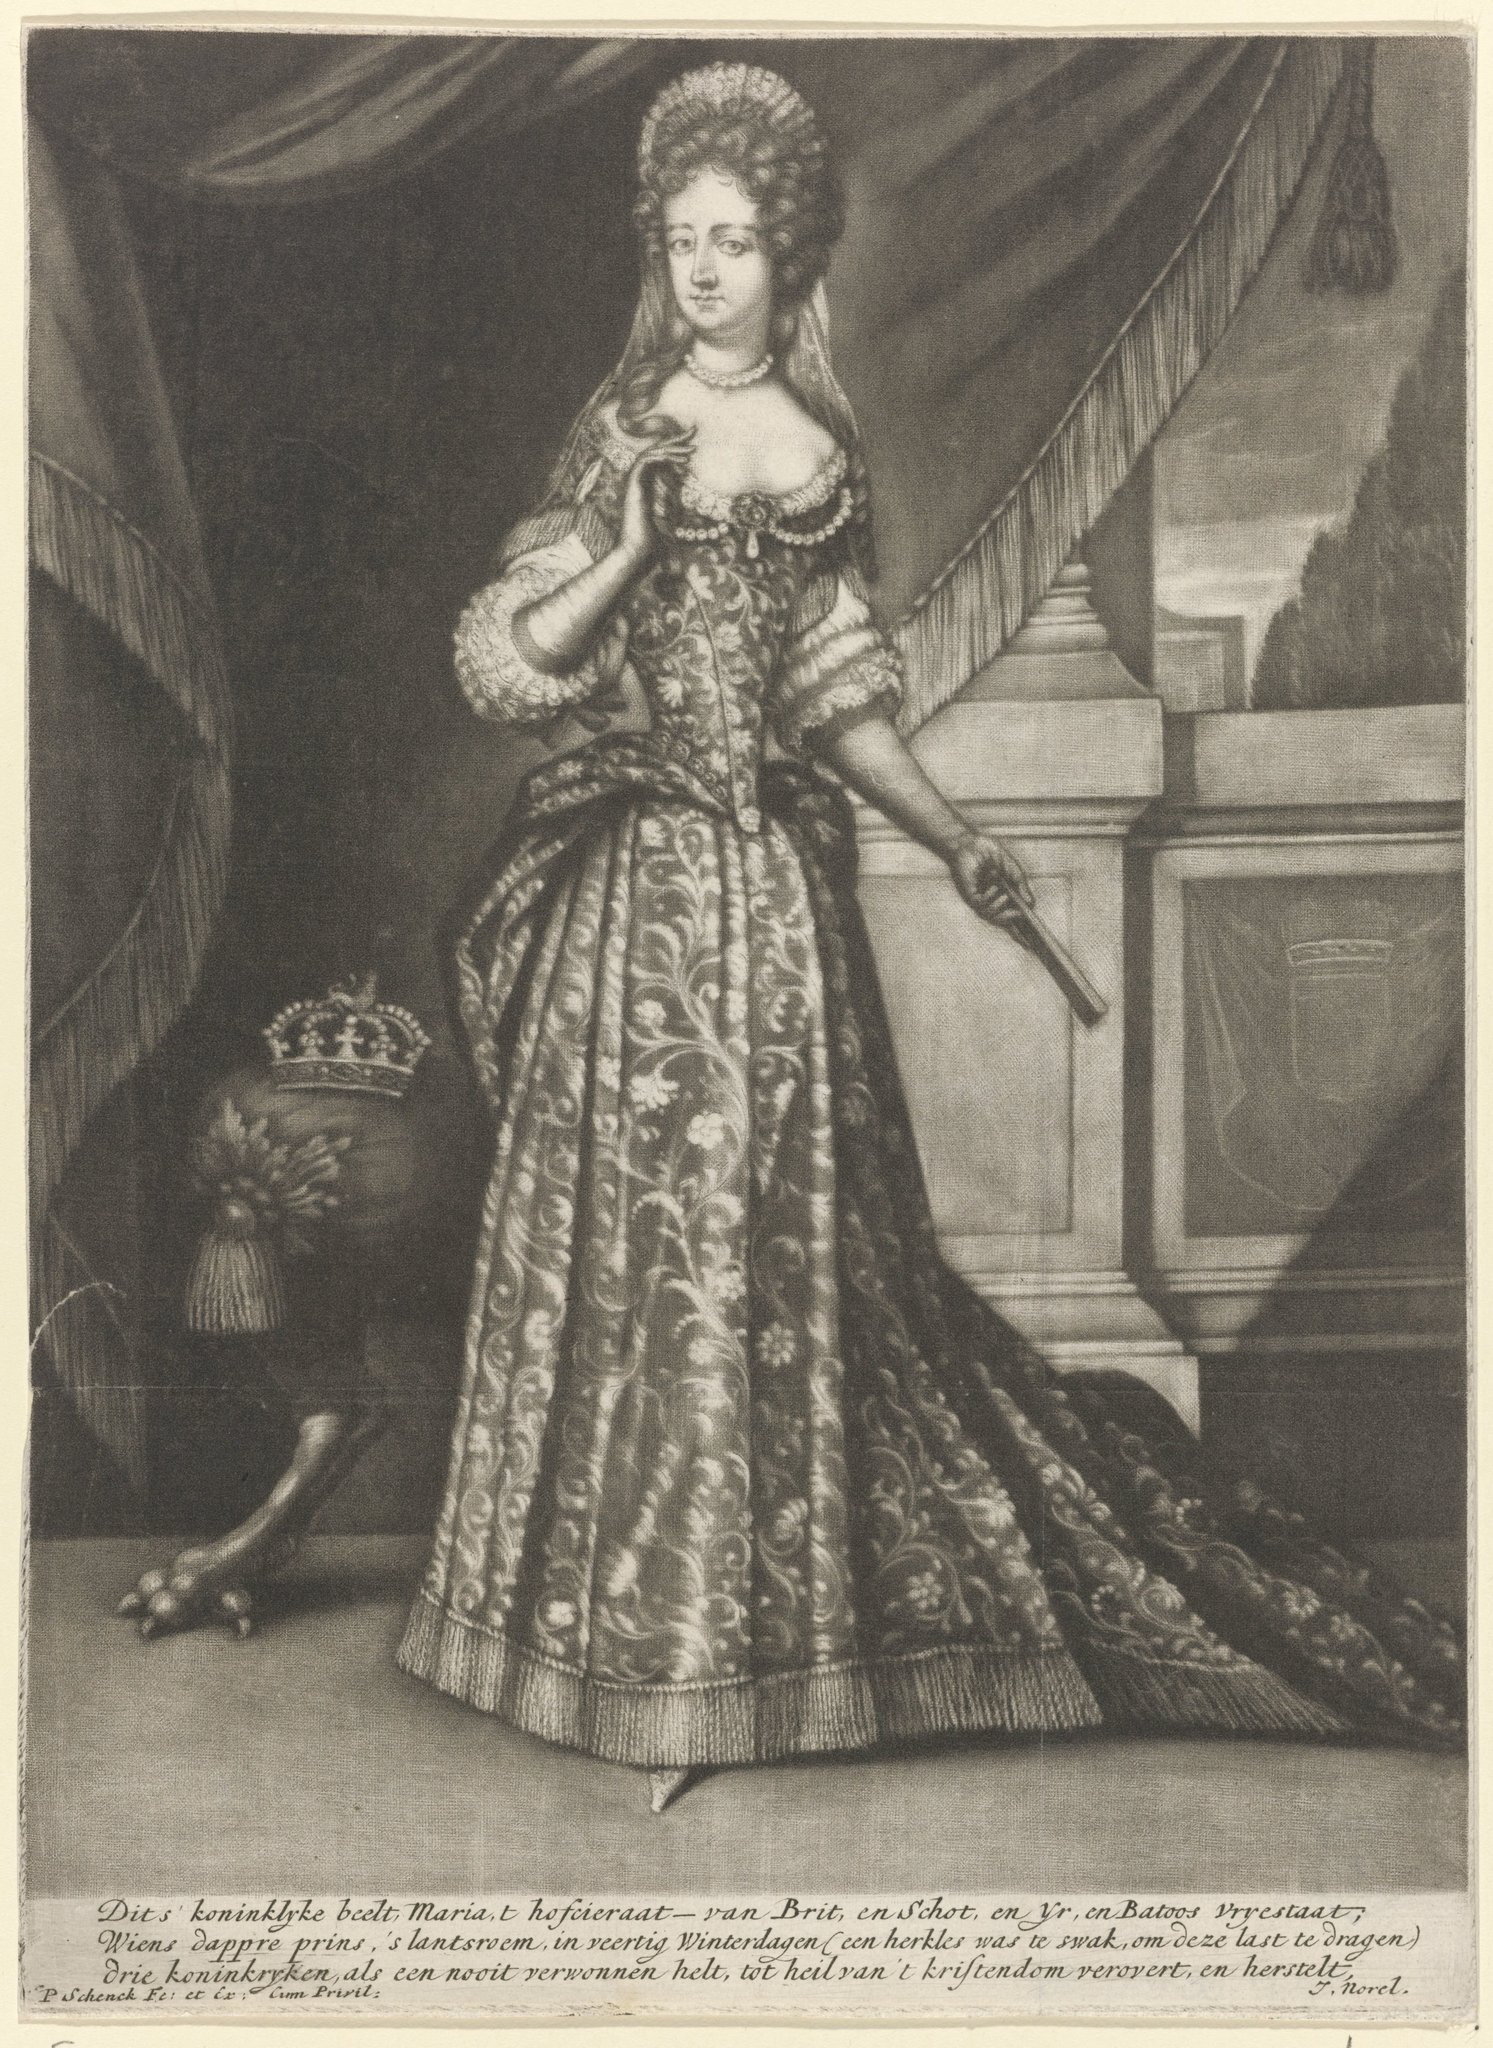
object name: print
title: Portret van Maria II Stuart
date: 1688-1711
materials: paper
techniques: engraving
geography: amsterdam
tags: london, maria ii stuart (koningin van engeland, schotland en ierland)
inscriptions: collector's mark: Lugt 963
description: Portret van Maria II. In haar linkerhand een waaier. Links een kroon. In de ondermarge drie regels Nederlandse tekst.